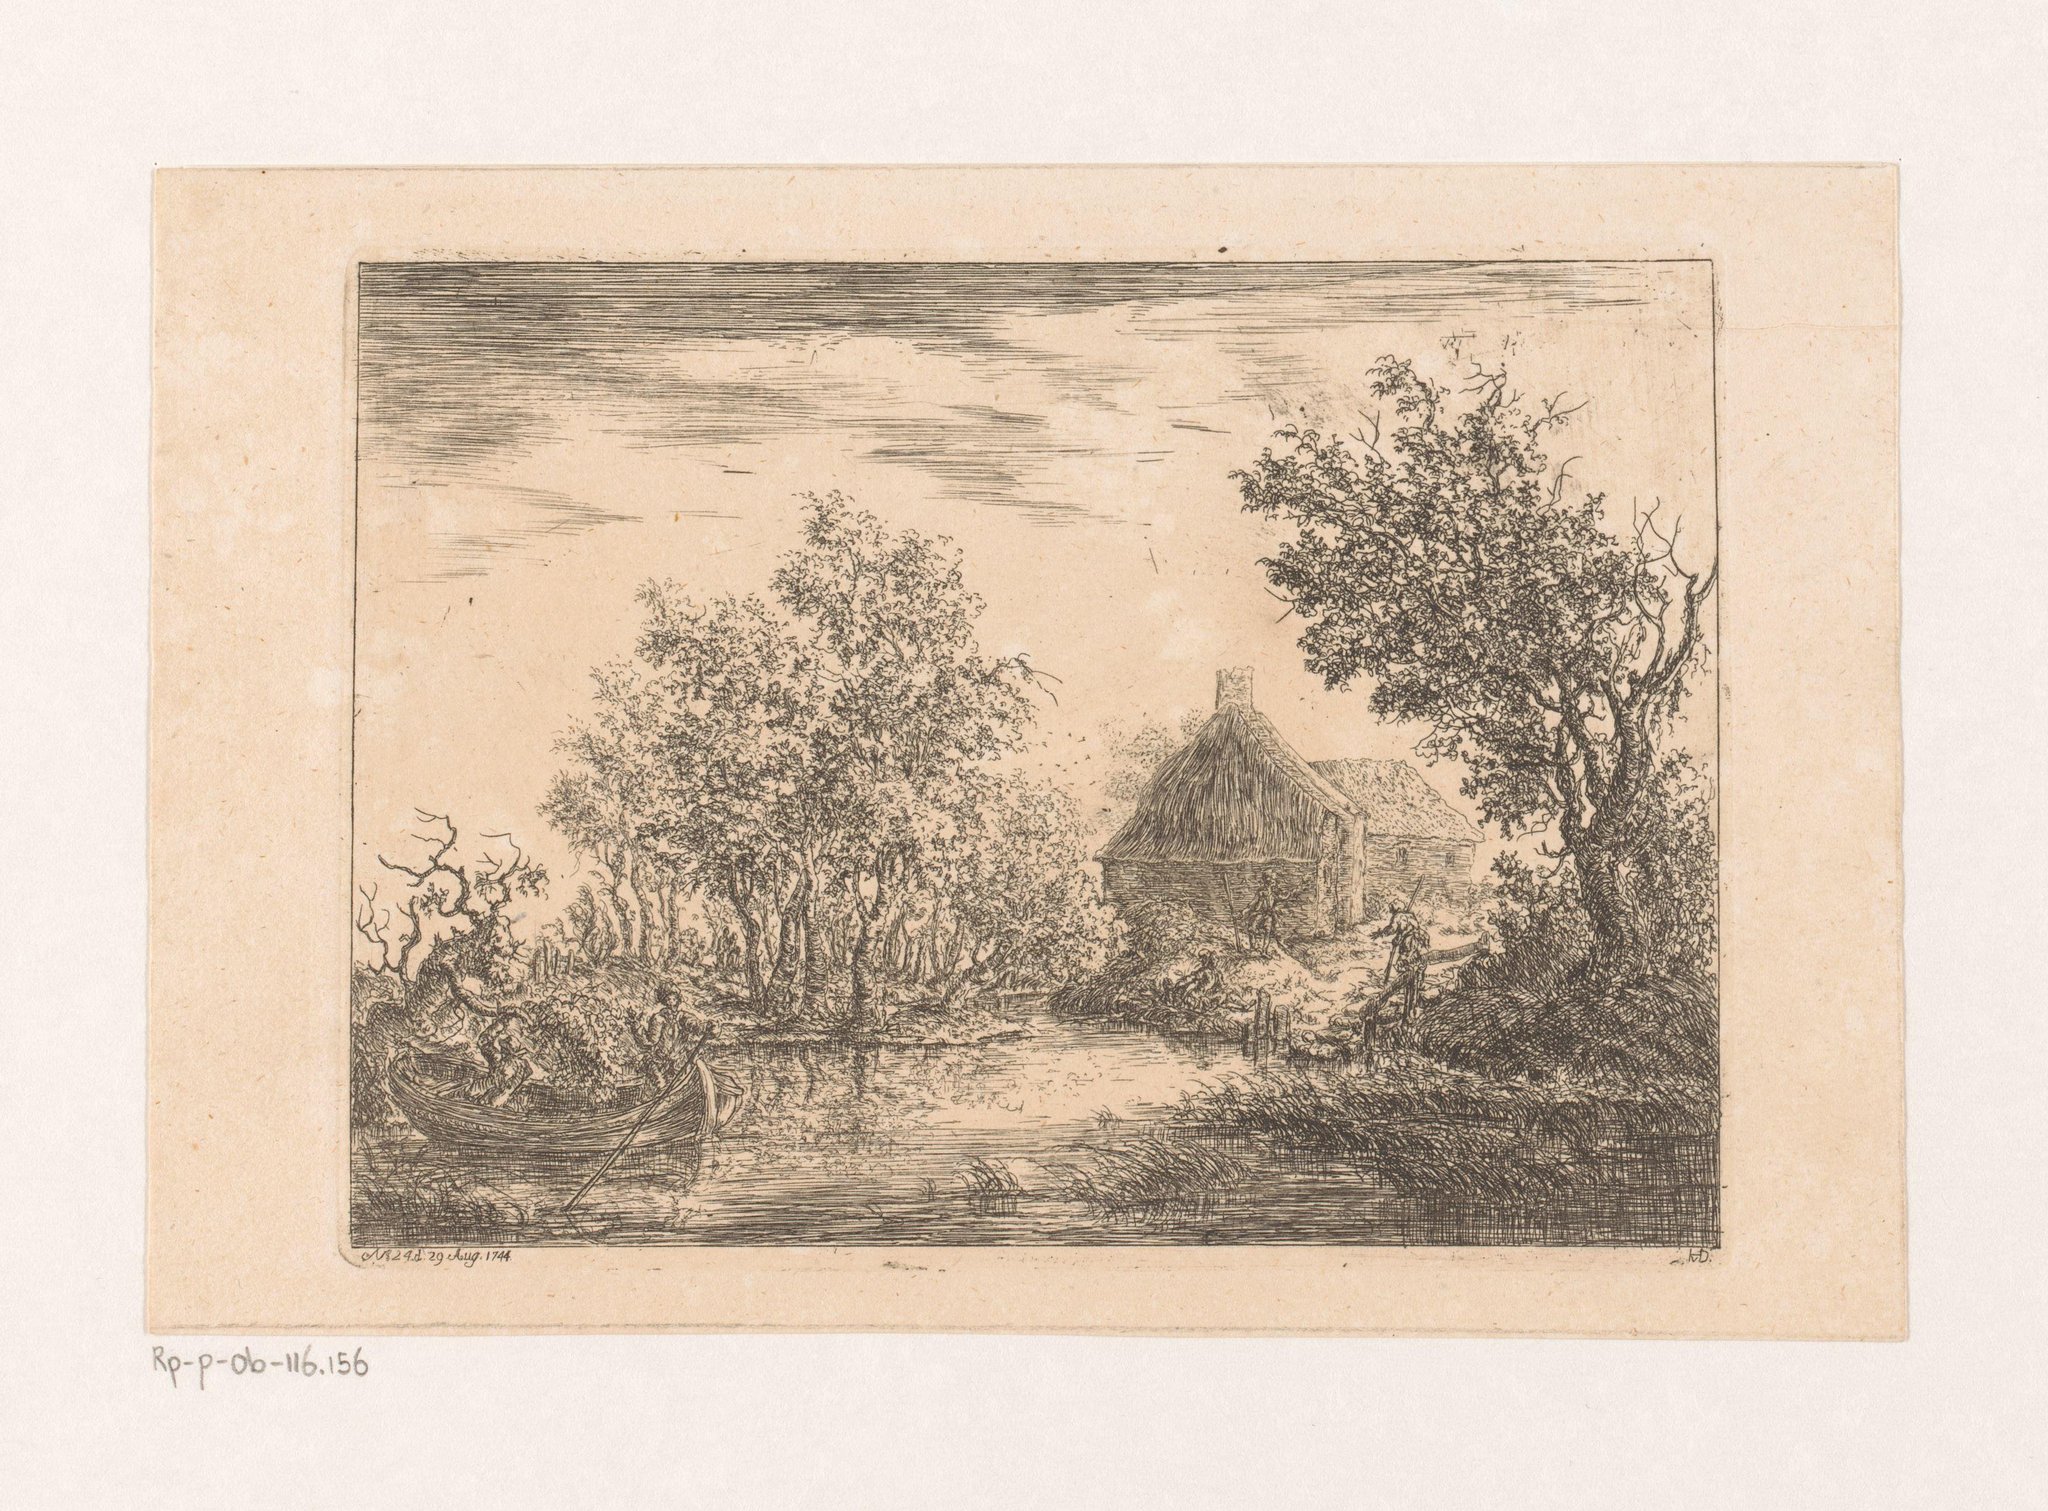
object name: print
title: Landschap met boerderij, op de voorgrond twee mannen in een boot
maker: christian ludwig von hagedorn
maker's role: painter, print maker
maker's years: 1712-1780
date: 1744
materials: paper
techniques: etching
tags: river (+ landscape with figures, staffage), farm or solitary house in landscape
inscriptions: collector's mark: Lugt 240